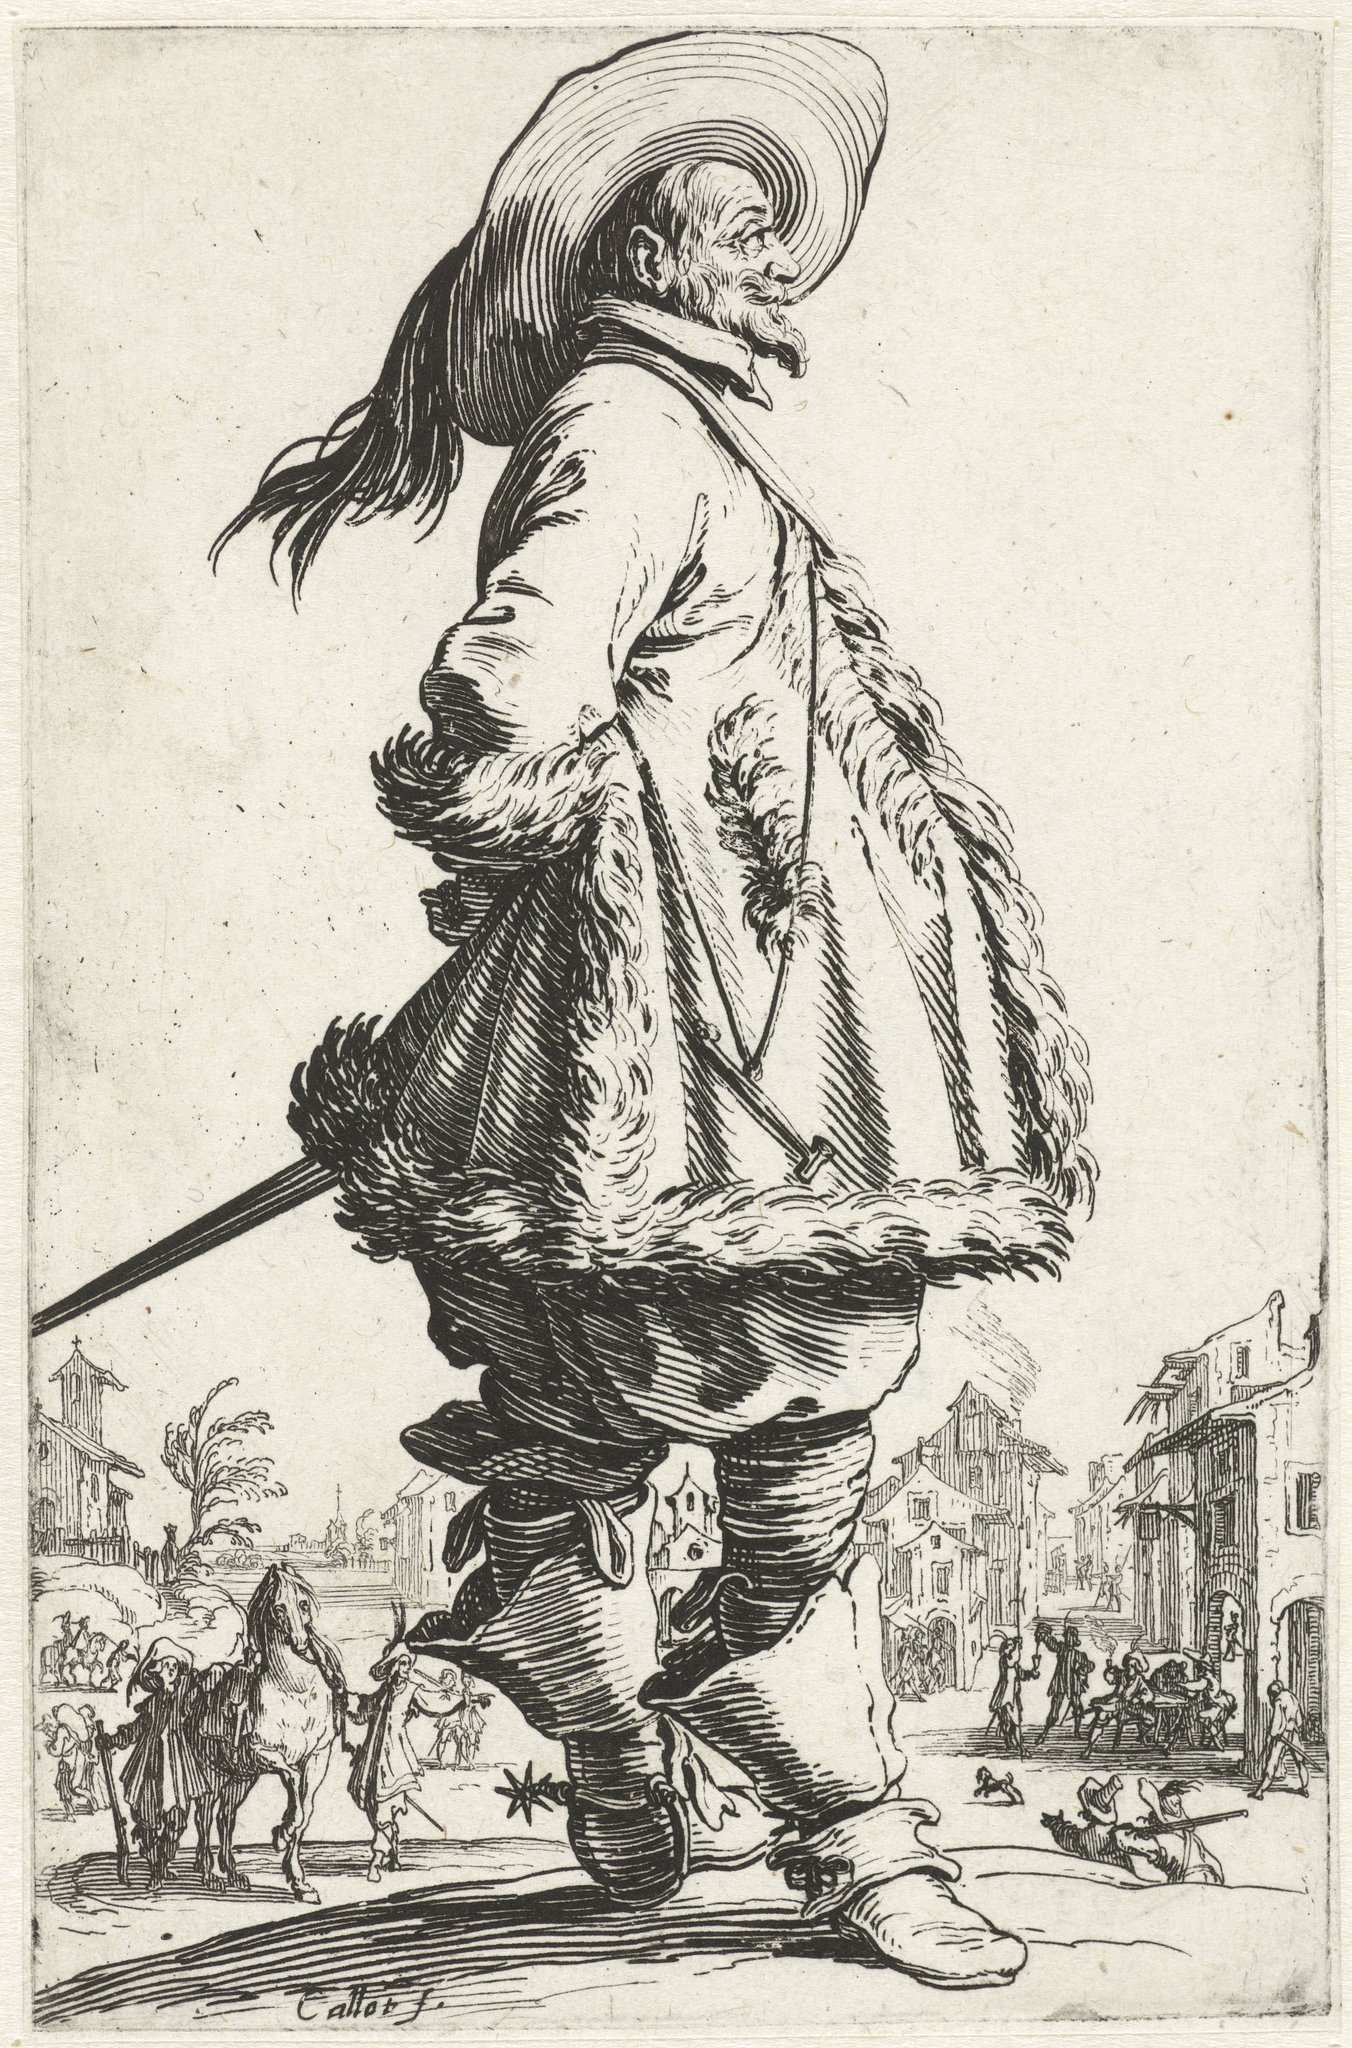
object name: costume print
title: Edellieden uit Lotharingen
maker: jacques callot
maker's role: draughtsman, print maker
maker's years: 1592-1635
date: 1620-1623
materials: paper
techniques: etching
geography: nancy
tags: coat (+ men's clothes), hacking and thrusting weapons: dagger, head-gear: hat (+ men's clothes), warfare; military affairs (+ cavalry, horsemen), clothes, costume (+ men's clothes), spur, trousers, breeches, etc. (breeches) (+ men's clothes), boots (+ men's clothes), head-gear: hat (+ feathers used for clothes), nobility and patriciate; chivalry, knighthood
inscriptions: collector's mark: Lugt 240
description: Staande heer, gekleed in een mantel afgezet met bont, laarzen met brede schachten en sporen aan de voeten, een hoed met brede rand en veer op het hoofd, de rechterhand op de rug. Op de achtergrond twee soldaten met een paard op een dorpsplein. Deze prent is onderdeel van een serie van 12 prenten met edellieden in kostuums die gedragen werden in Lotharingen in het eerste kwart van de 17e eeuw; de helft van de serie betreft herenkostuums, de andere helft toont dameskostuums.